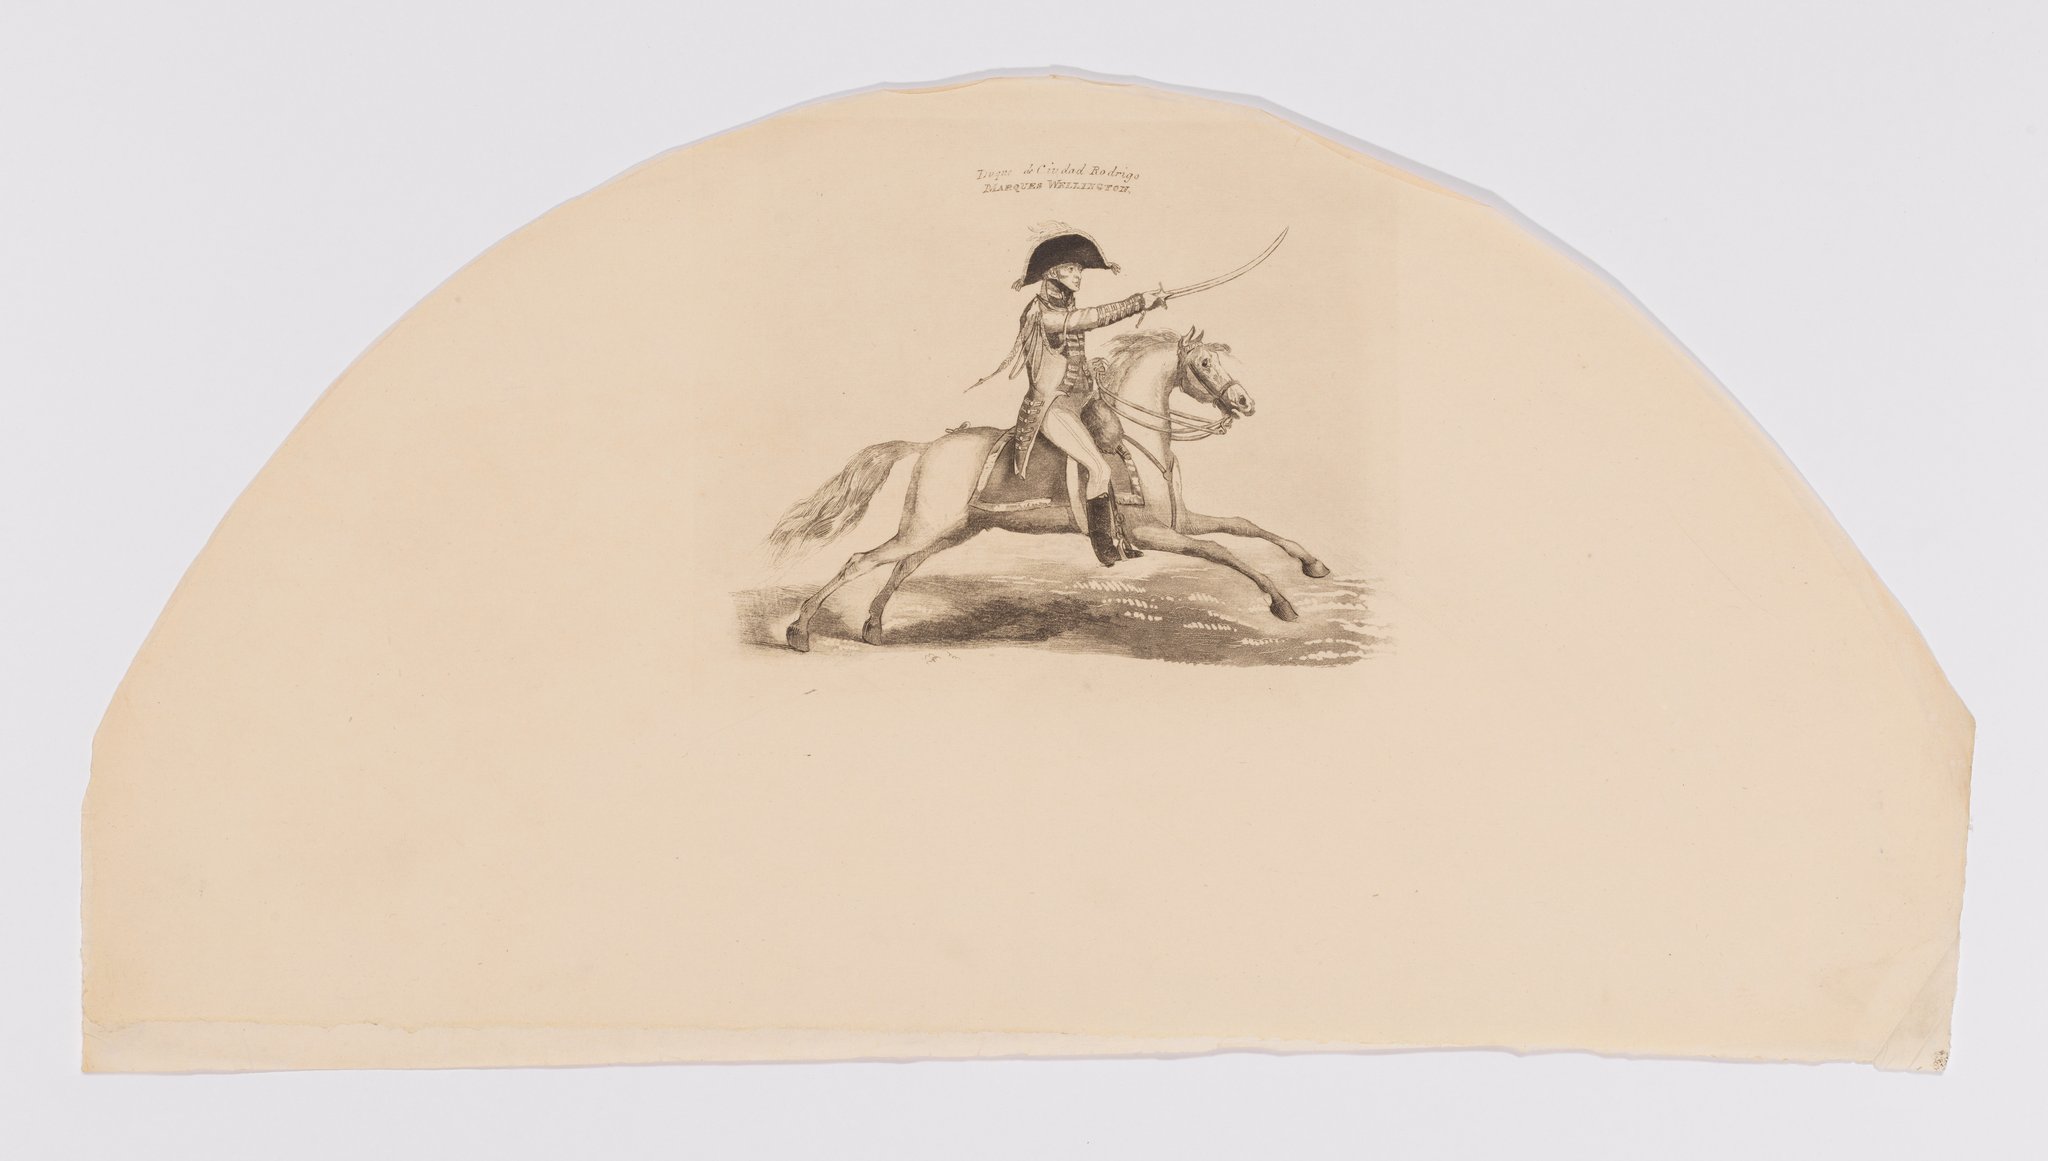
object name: print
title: Fan leaf showing the Duke of Wellington in uniform on horseback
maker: anonymous, british, 19th century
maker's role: artist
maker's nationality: british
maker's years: 1800-1900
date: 1801-1900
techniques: etching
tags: men,horses